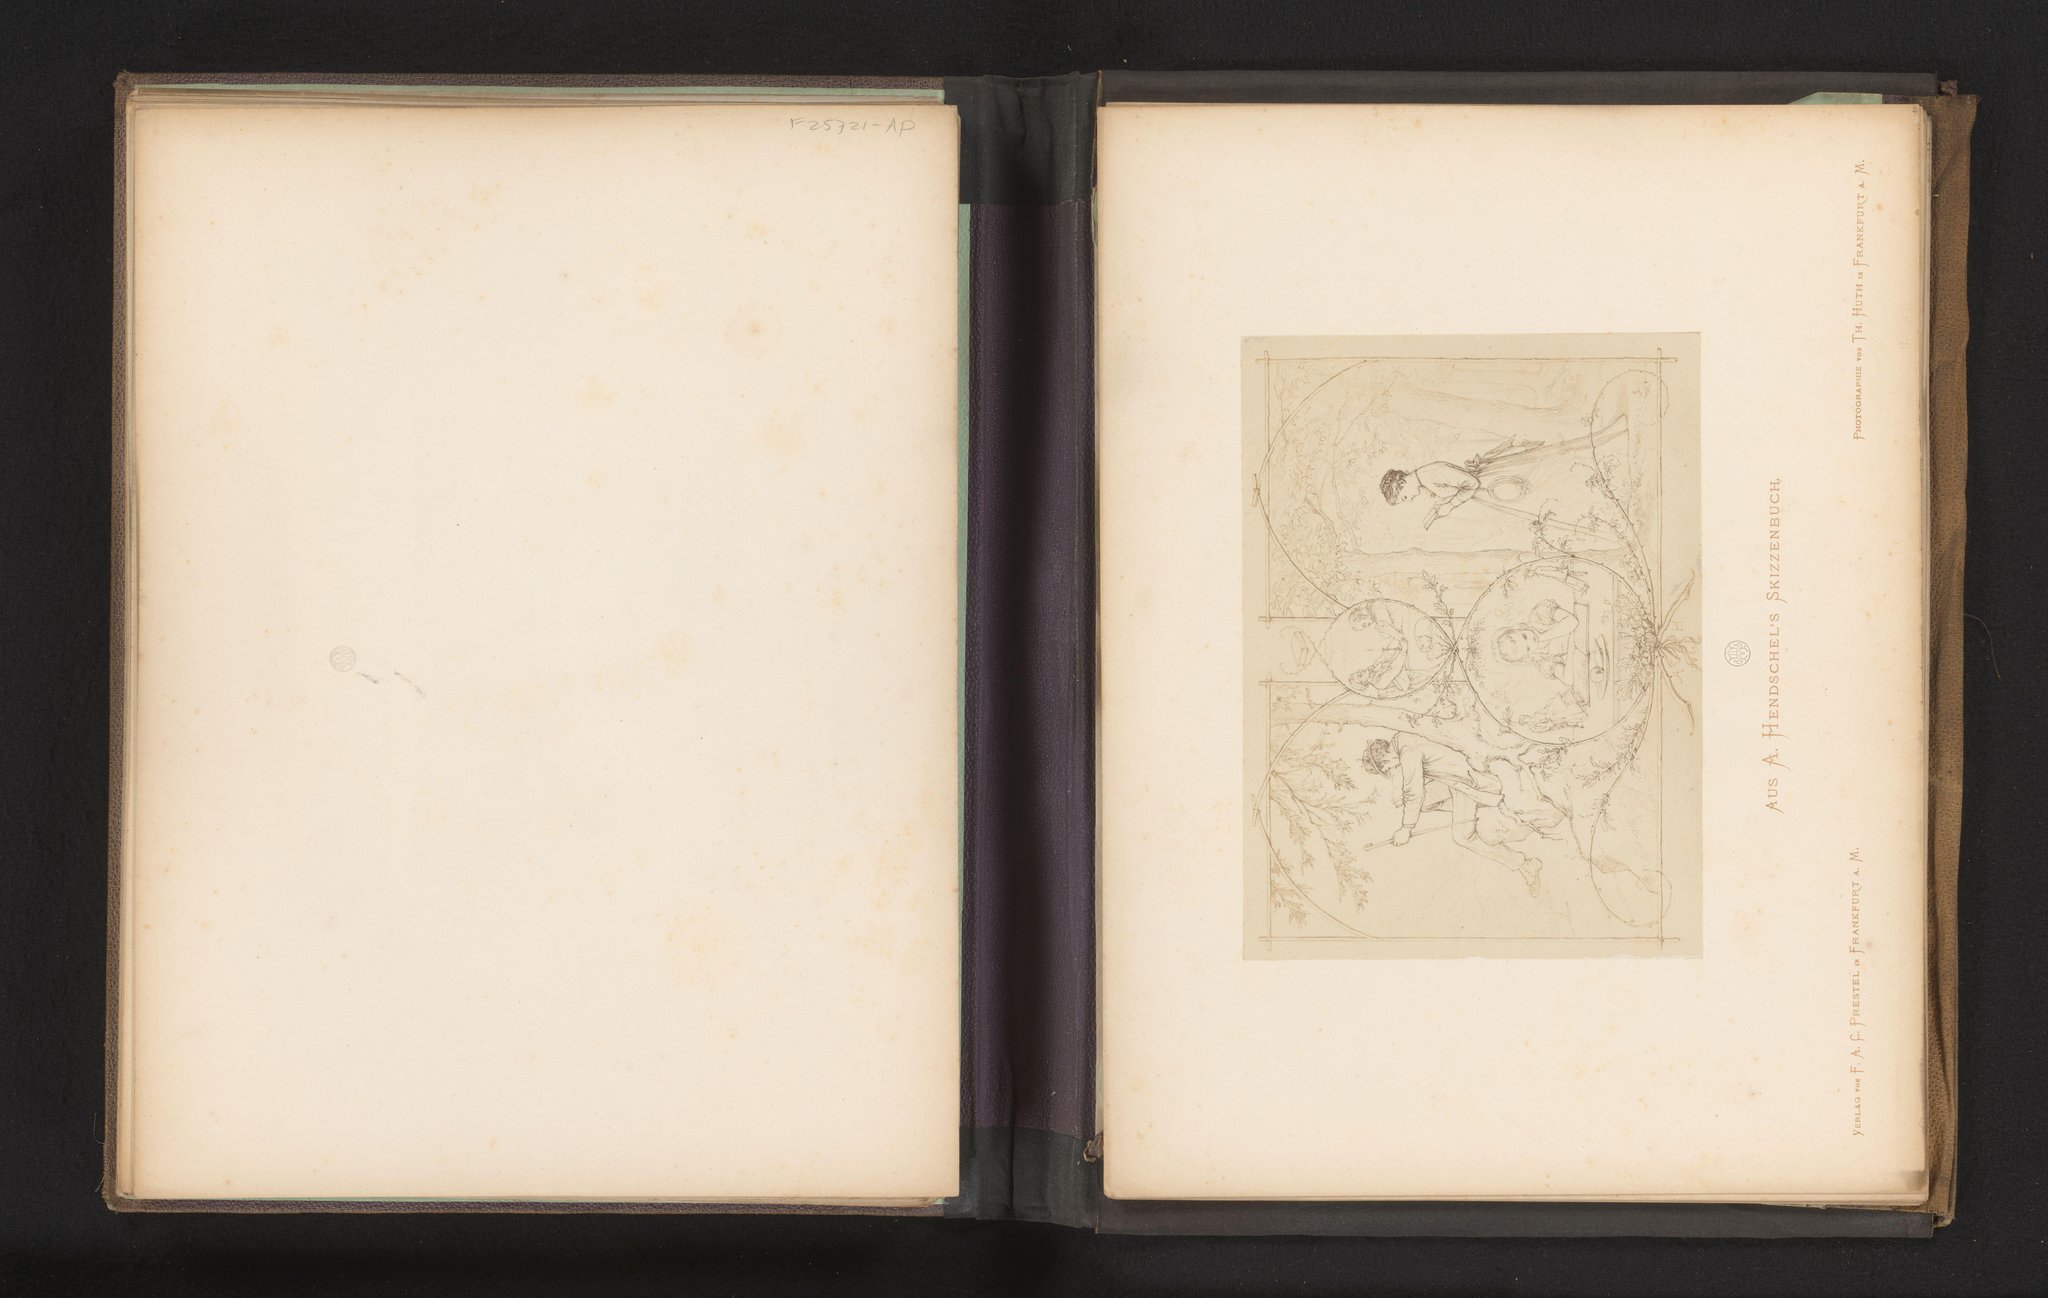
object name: reproduction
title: Fotoreproductie van een schets van verschillende lezende figuren door Albert Hendschel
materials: paper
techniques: albumen print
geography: frankfurt am main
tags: adult woman, reading, adult man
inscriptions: monogram: ‘AH’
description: Deze foto maakt deel uit van een omslag met 50 foto's op 48 bladen, een lijst van afbeeldingen en een titelblad.